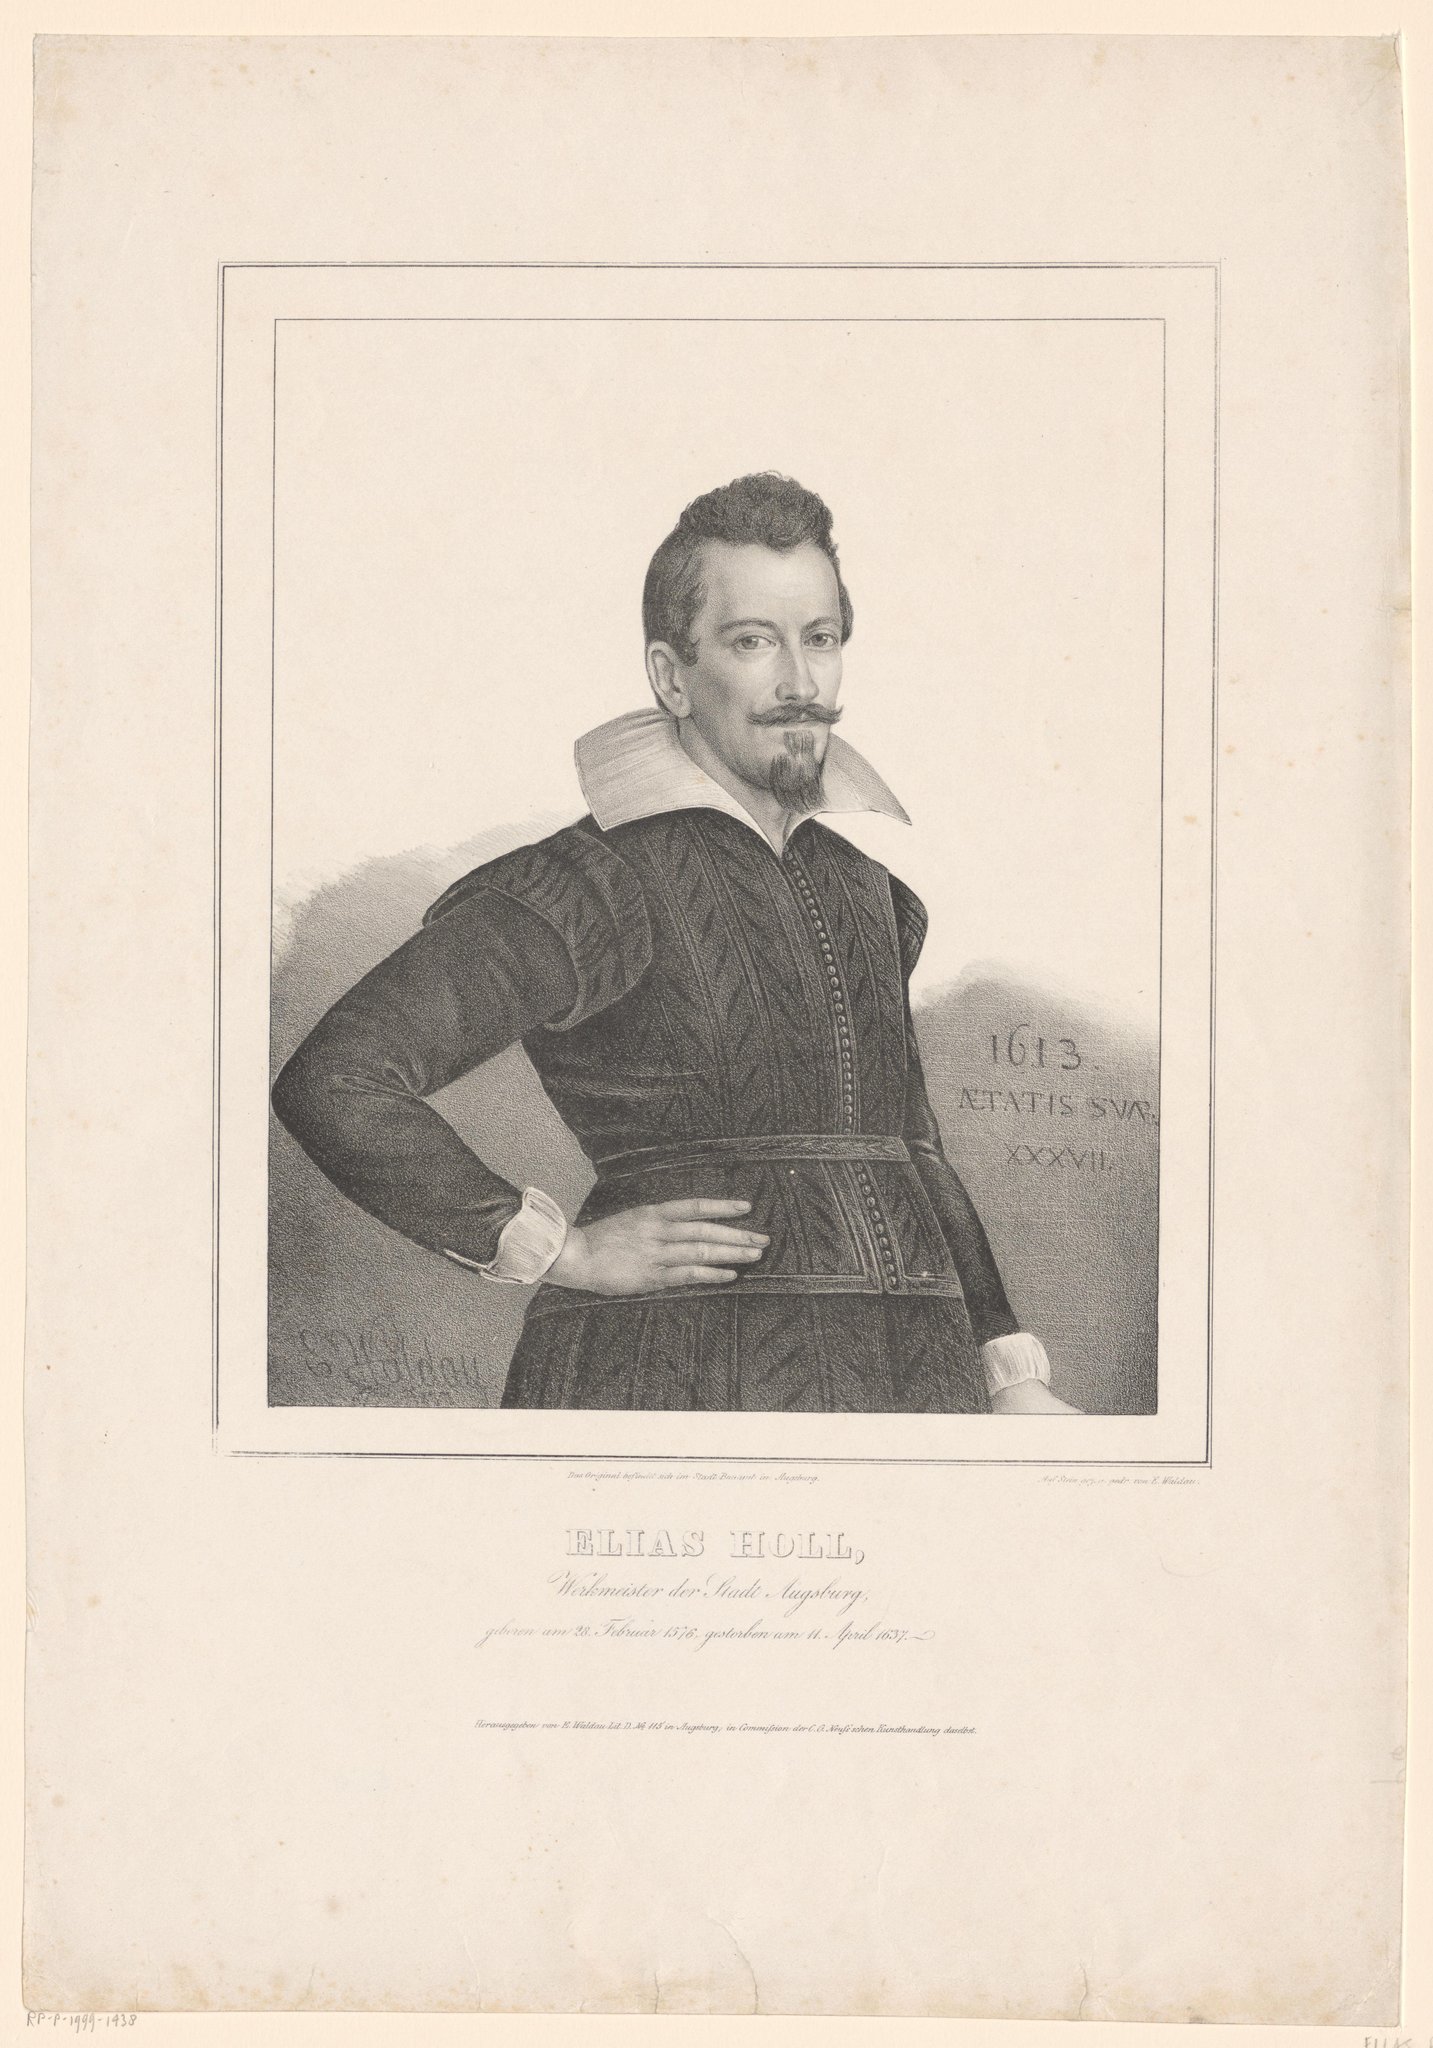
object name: print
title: Elias Holl, Werkmeister der Stadt Augsburg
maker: e. waldau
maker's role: print maker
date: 1825-1874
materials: paper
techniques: lithograph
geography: augsburg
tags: augsburg, elias holl, historical persons, portrait, self-portrait of architect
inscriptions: collector's mark: Lugt 2026, collector's mark: Lugt 2228, collector's mark: Lugt 2760